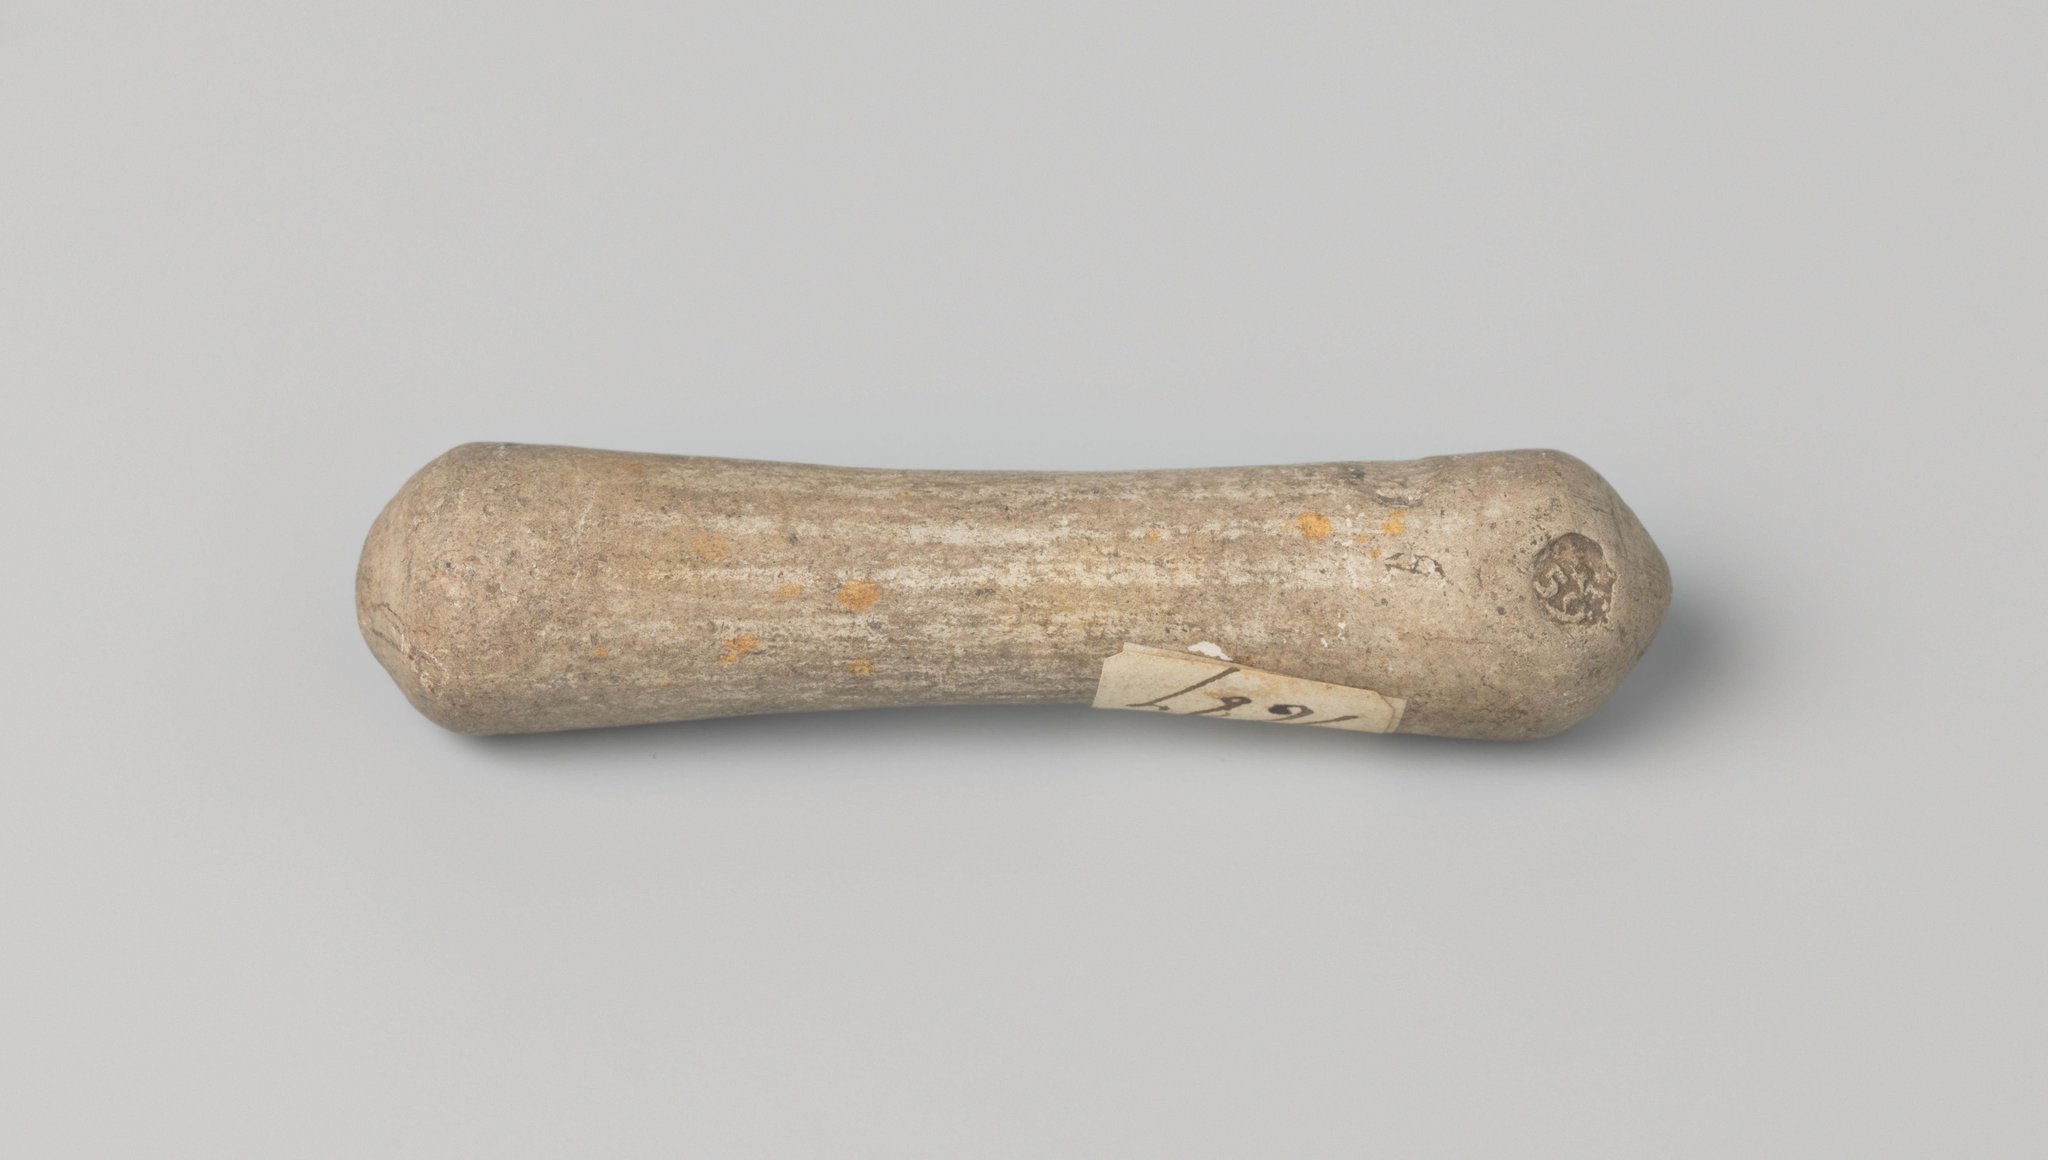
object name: staaf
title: Rod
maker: Anonymous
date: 1600-1800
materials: earthenware, clay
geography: europe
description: Staaf van pijpaarde met het merk 59. Een krulspeld van een pruikenmaker.